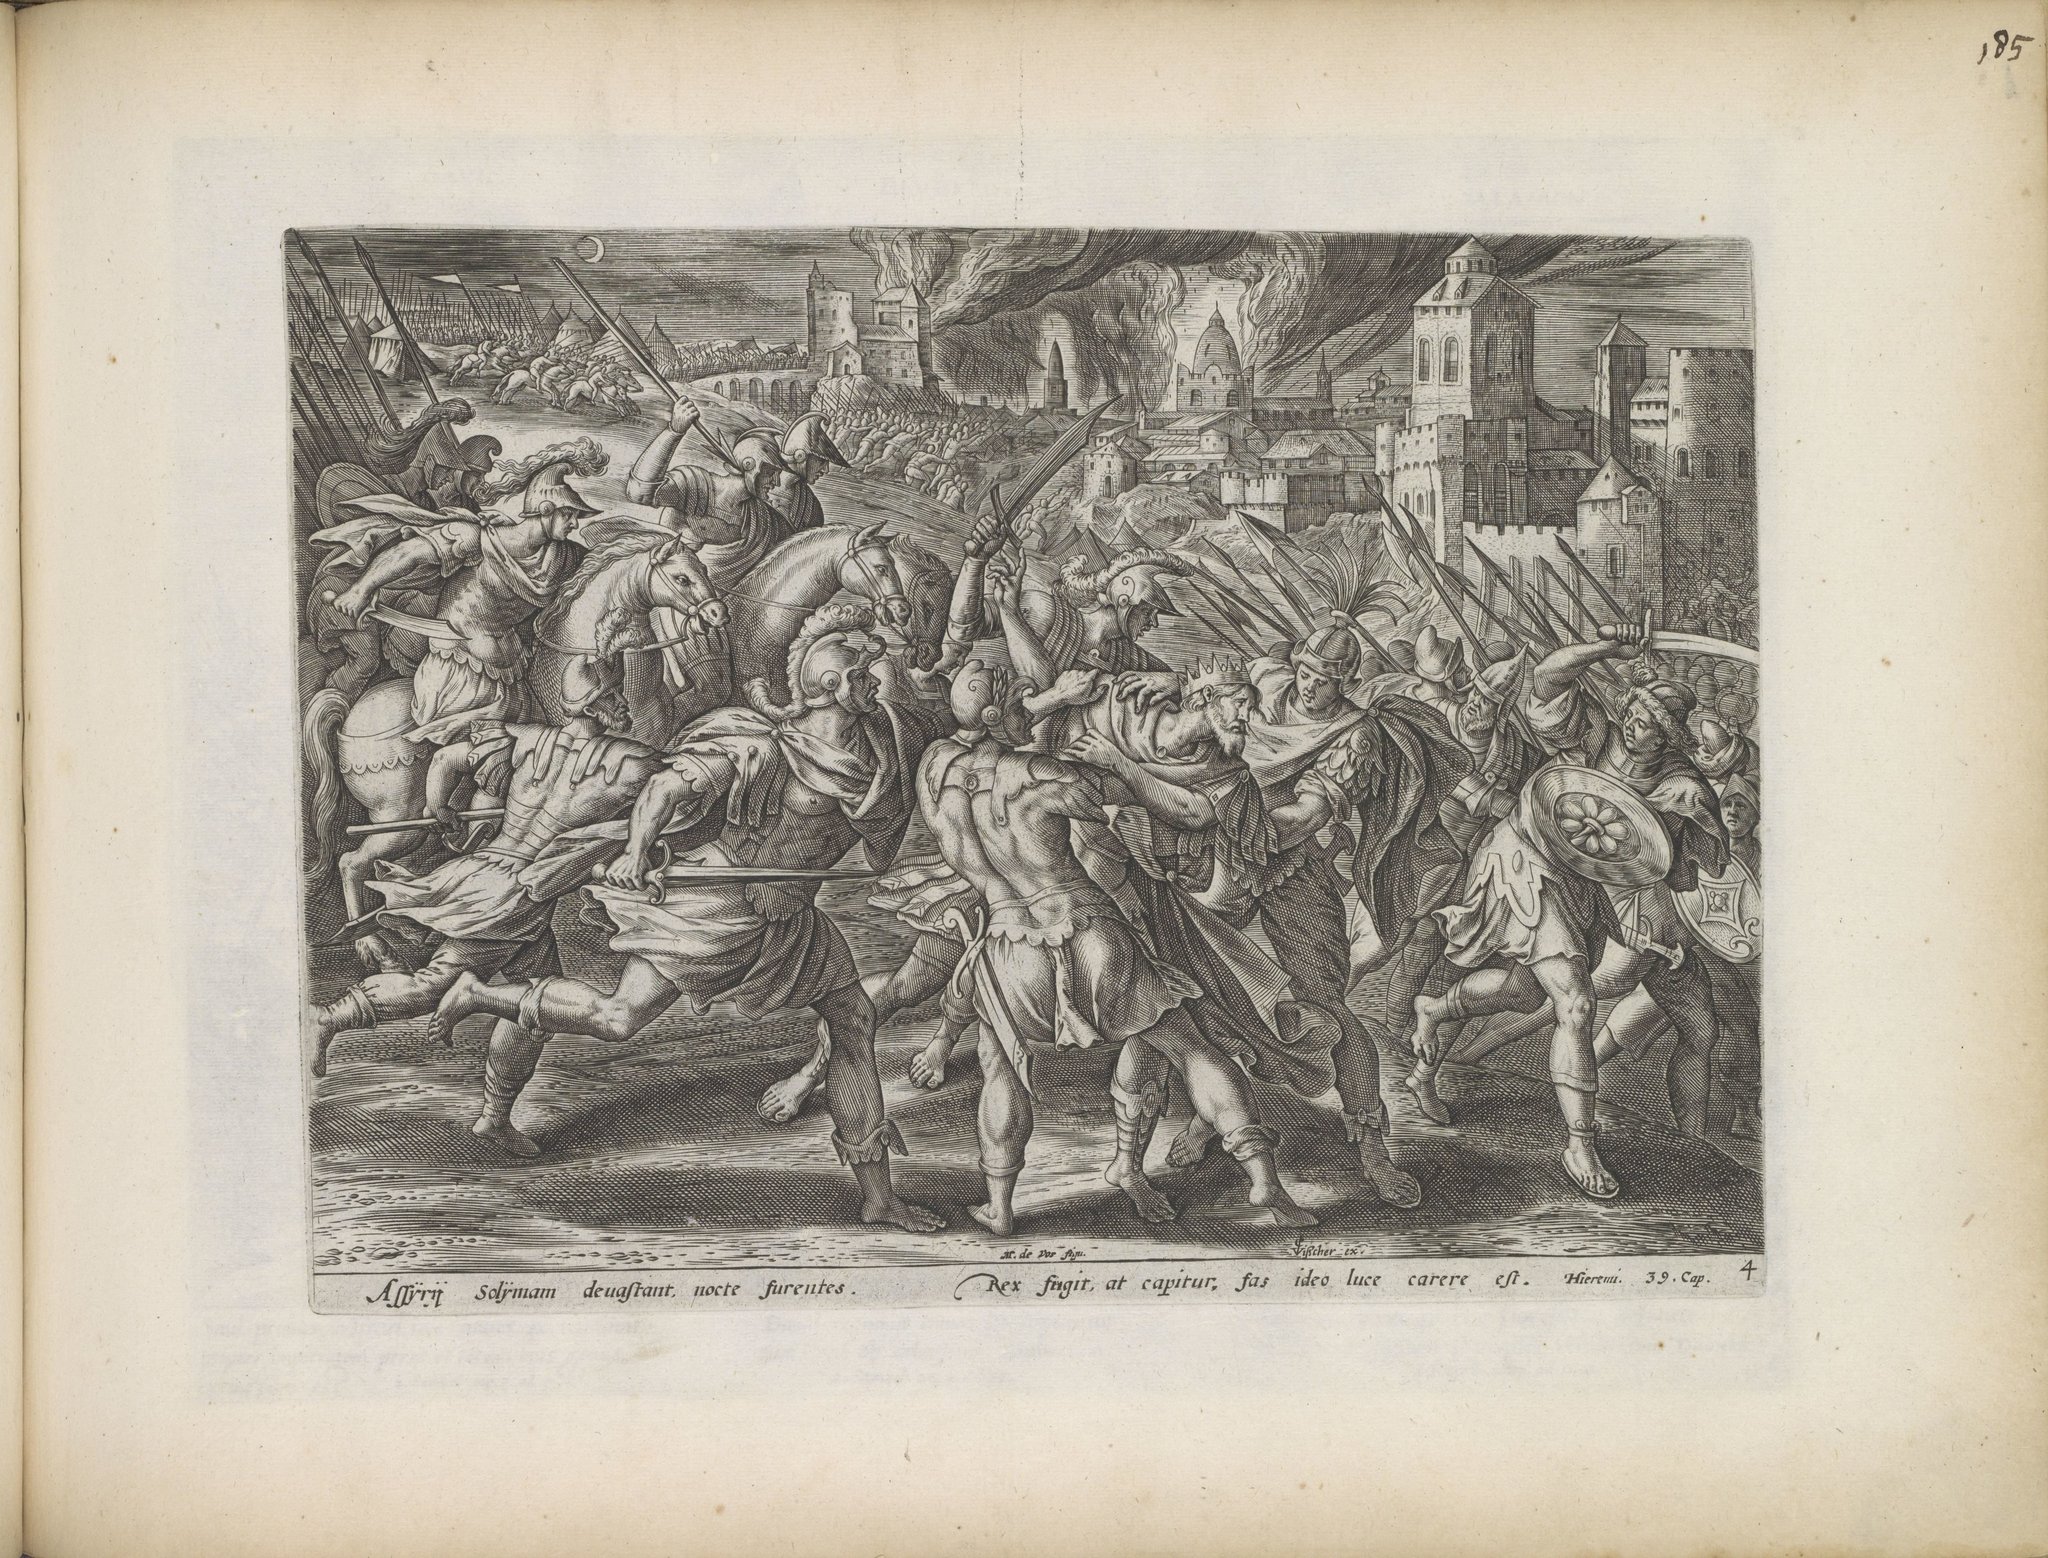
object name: album leaf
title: Geschiedenis van Jeremia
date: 1585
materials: paper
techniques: engraving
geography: amsterdam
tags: zedekiah is captured by the babylonians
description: Als koning Sedekia ’s nachts de stad uitvlucht in de richting van de Jordaanvallei wordt hij door het Chaldese leger op de vlakte van Jericho gevangen genomen. Onder de voorstelling een verwijzing in het Latijn naar de Bijbeltekst in Jer. 39. Deze prent maakt deel uit van een album.